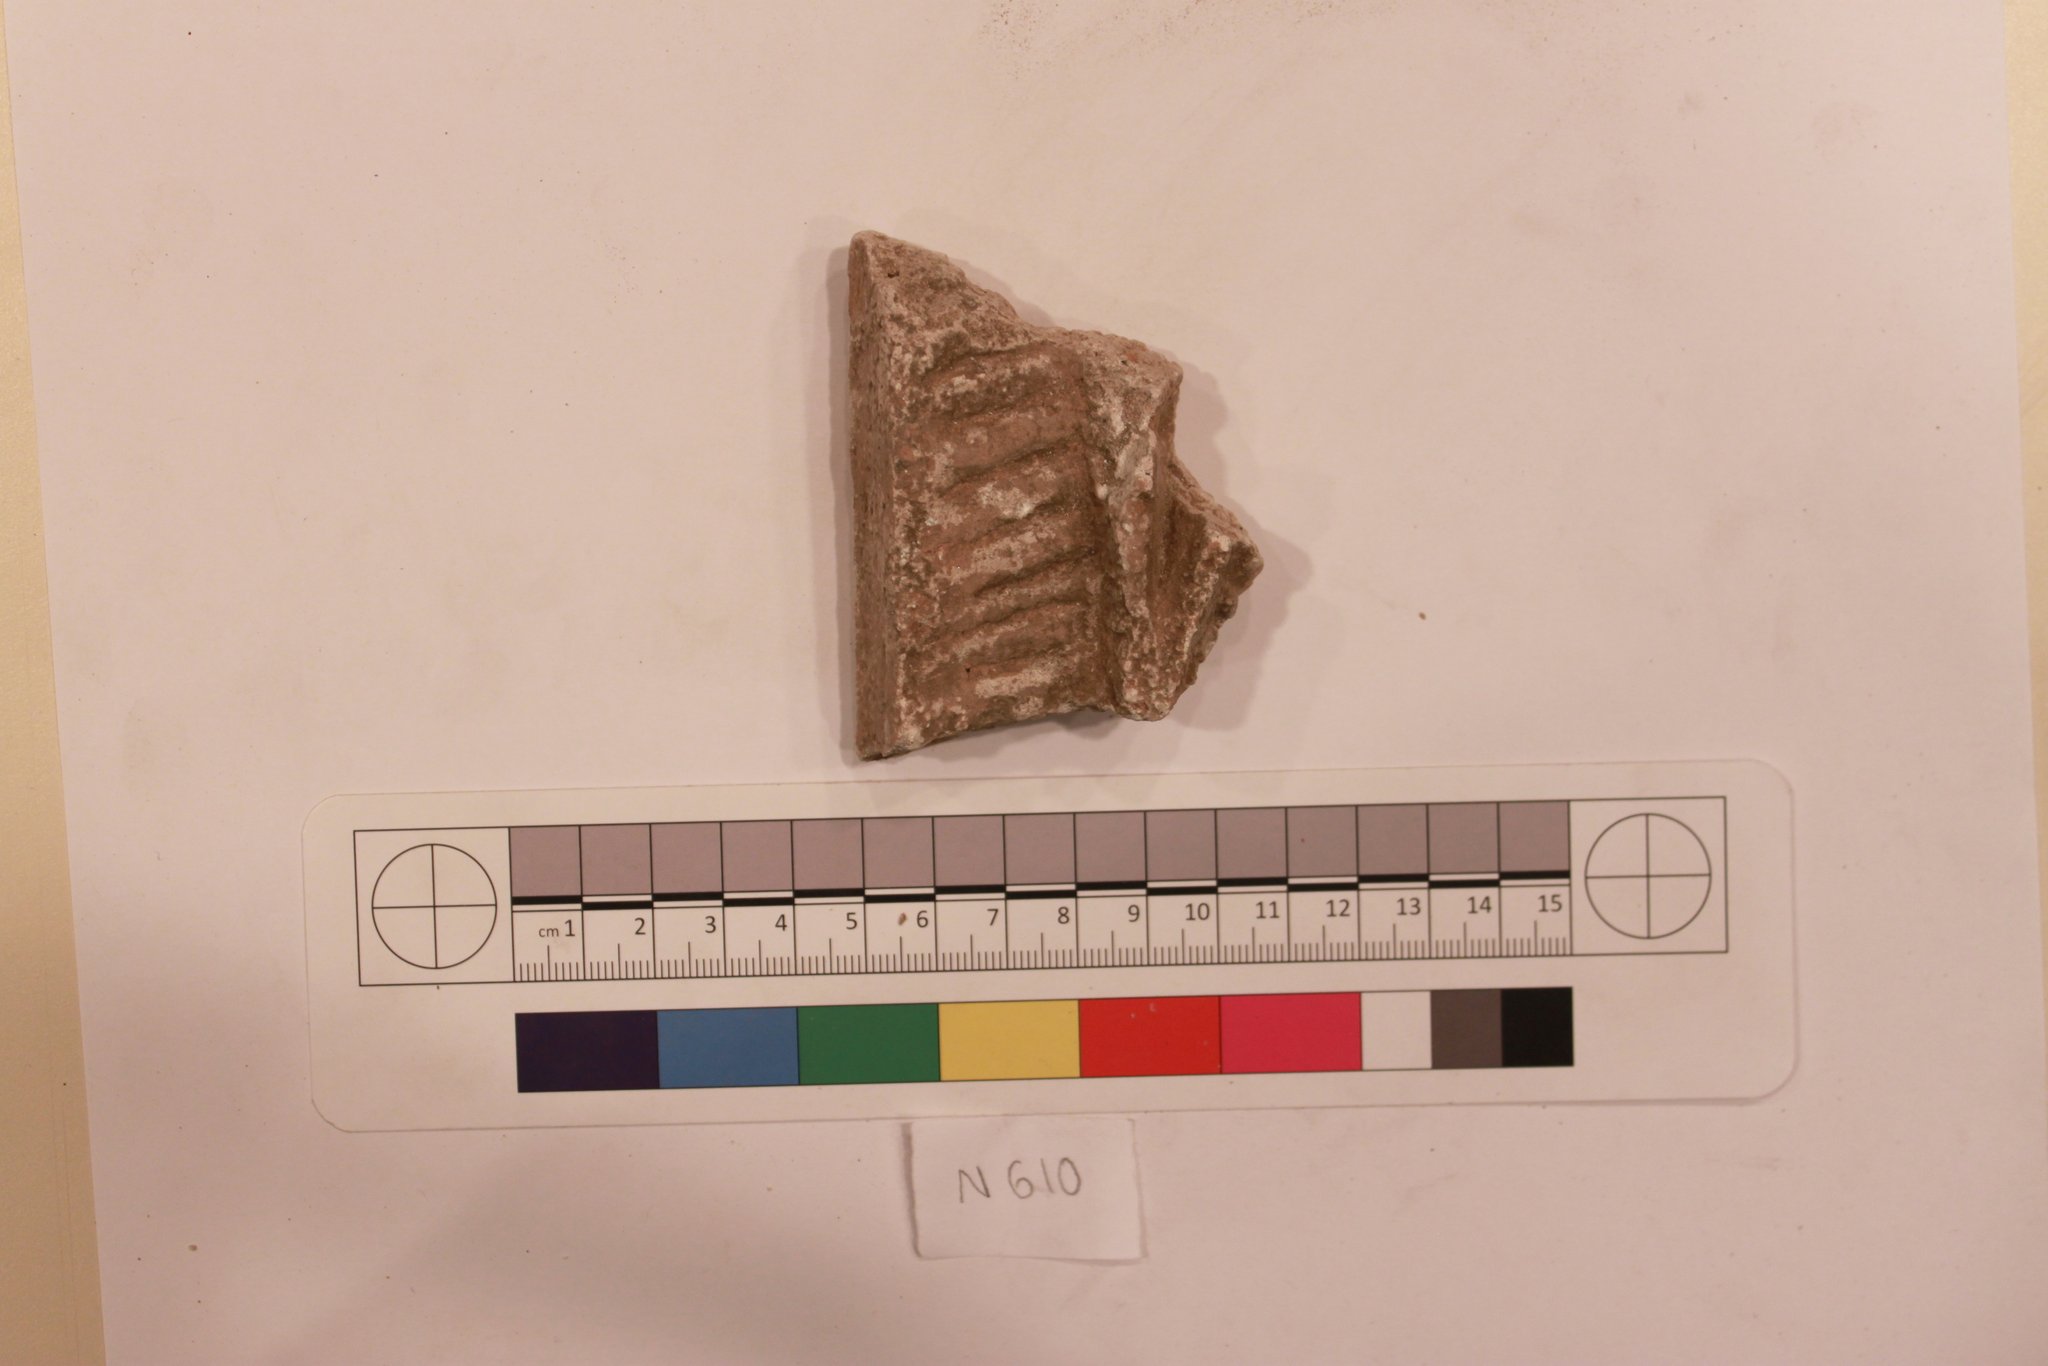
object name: fragment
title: Stucco Fragment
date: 701-1200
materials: plaster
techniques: carving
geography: iran